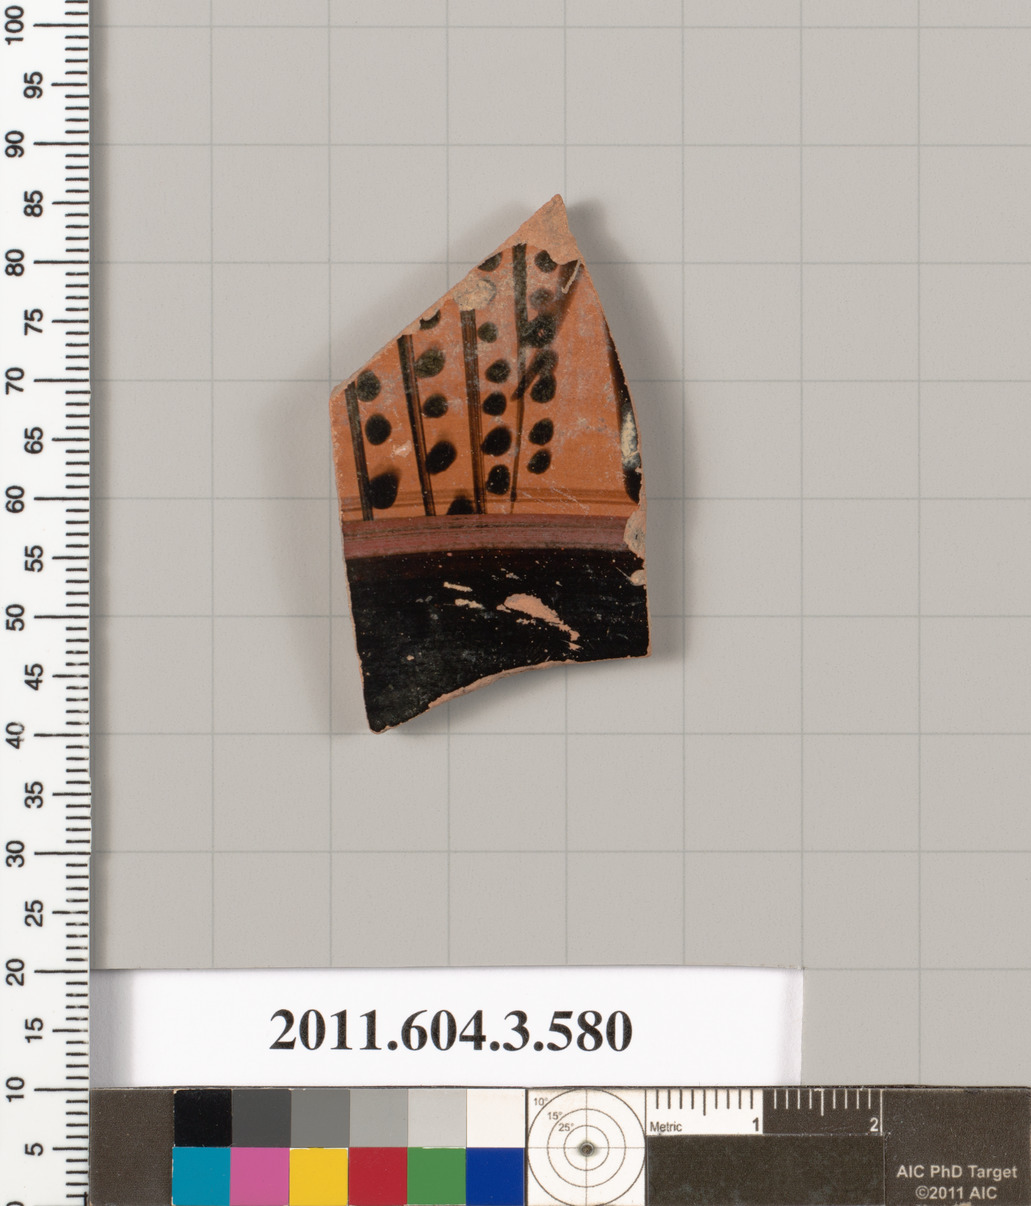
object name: column krater fragment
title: Terracotta fragment of a column-krater (bowl for mixing wine and water)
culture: greek, attic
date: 500-468 BCE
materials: terracotta